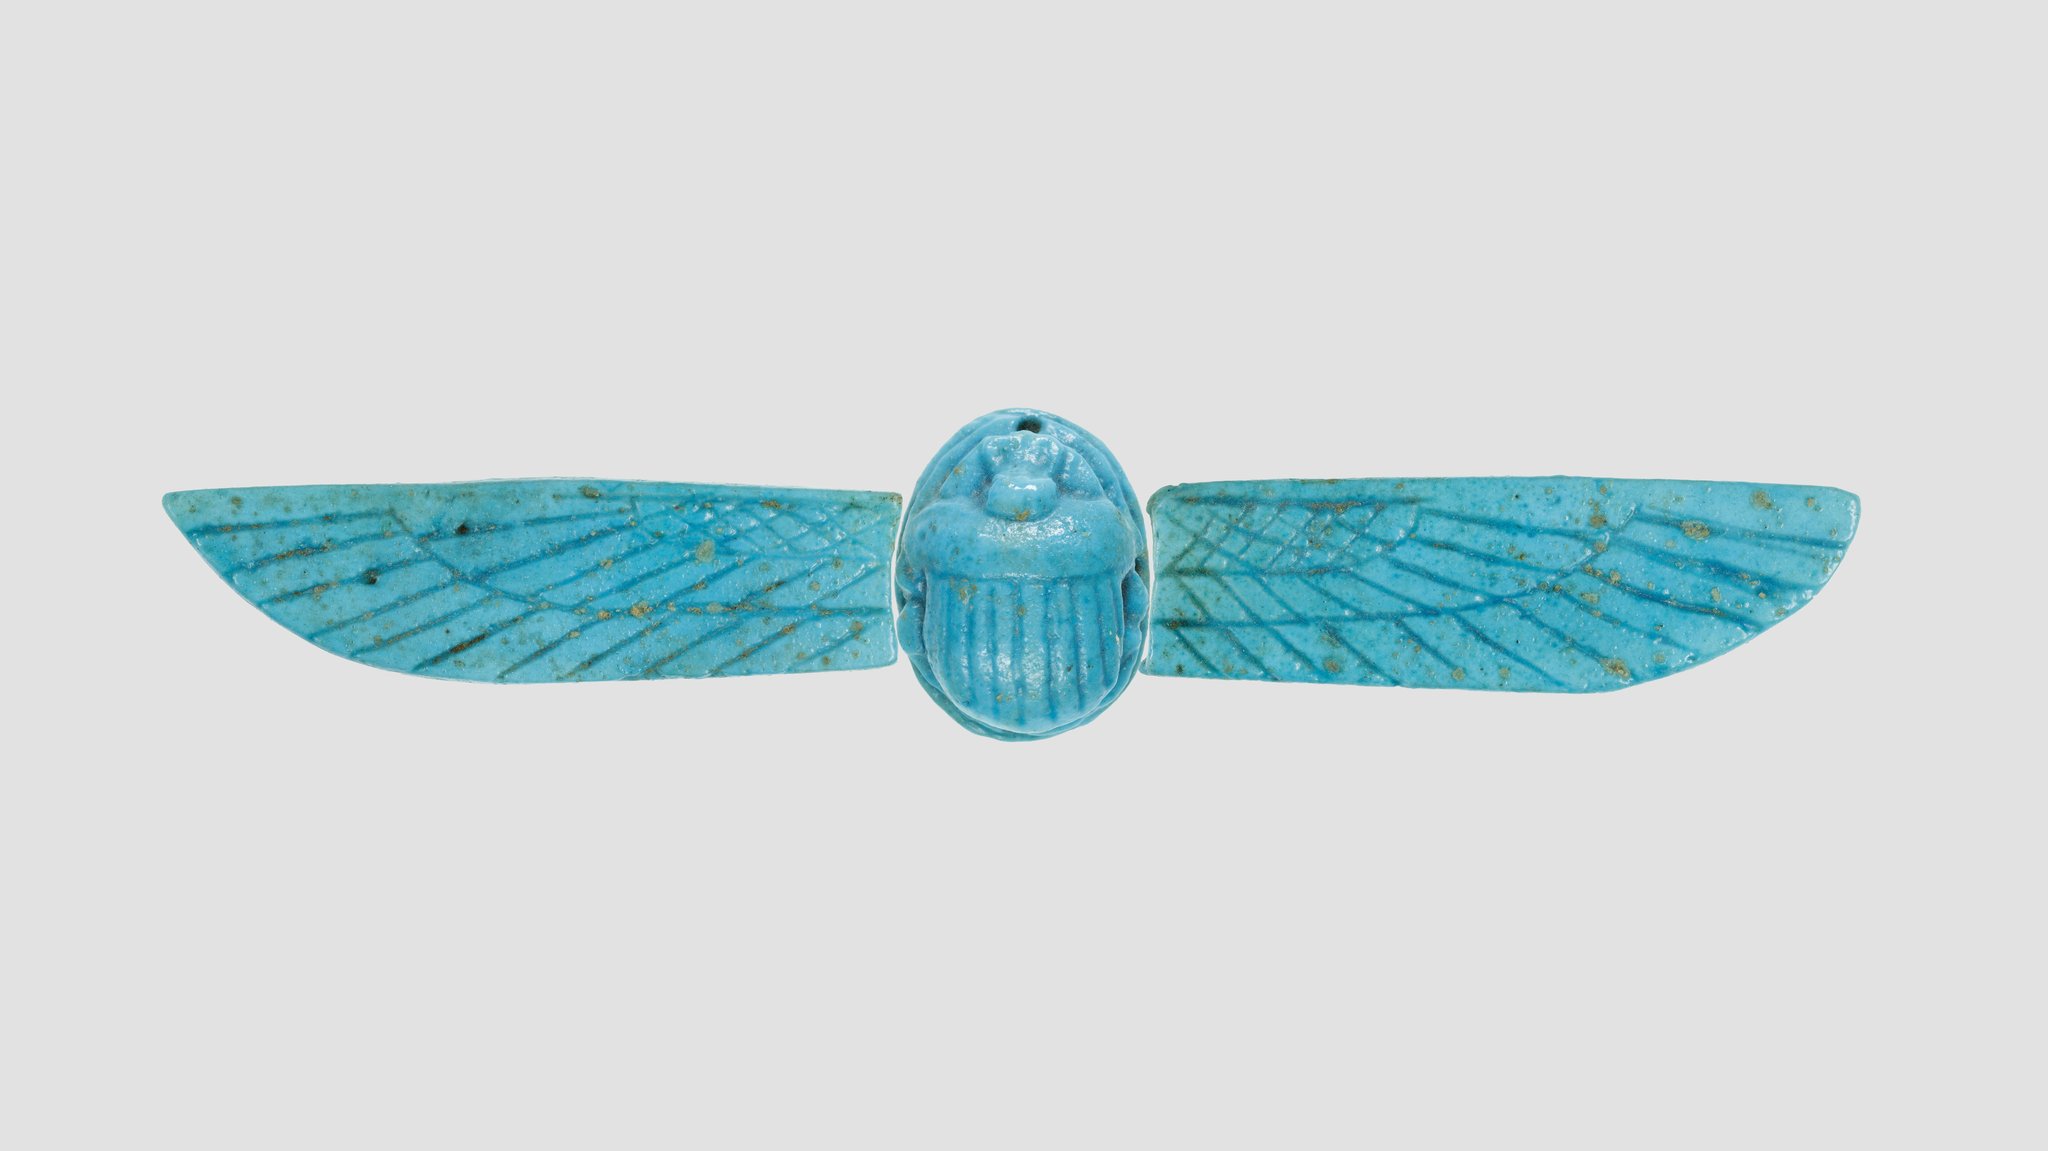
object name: amulet, winged scarab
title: Winged Scarab Amulet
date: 664-332 BCE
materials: faience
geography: egypt